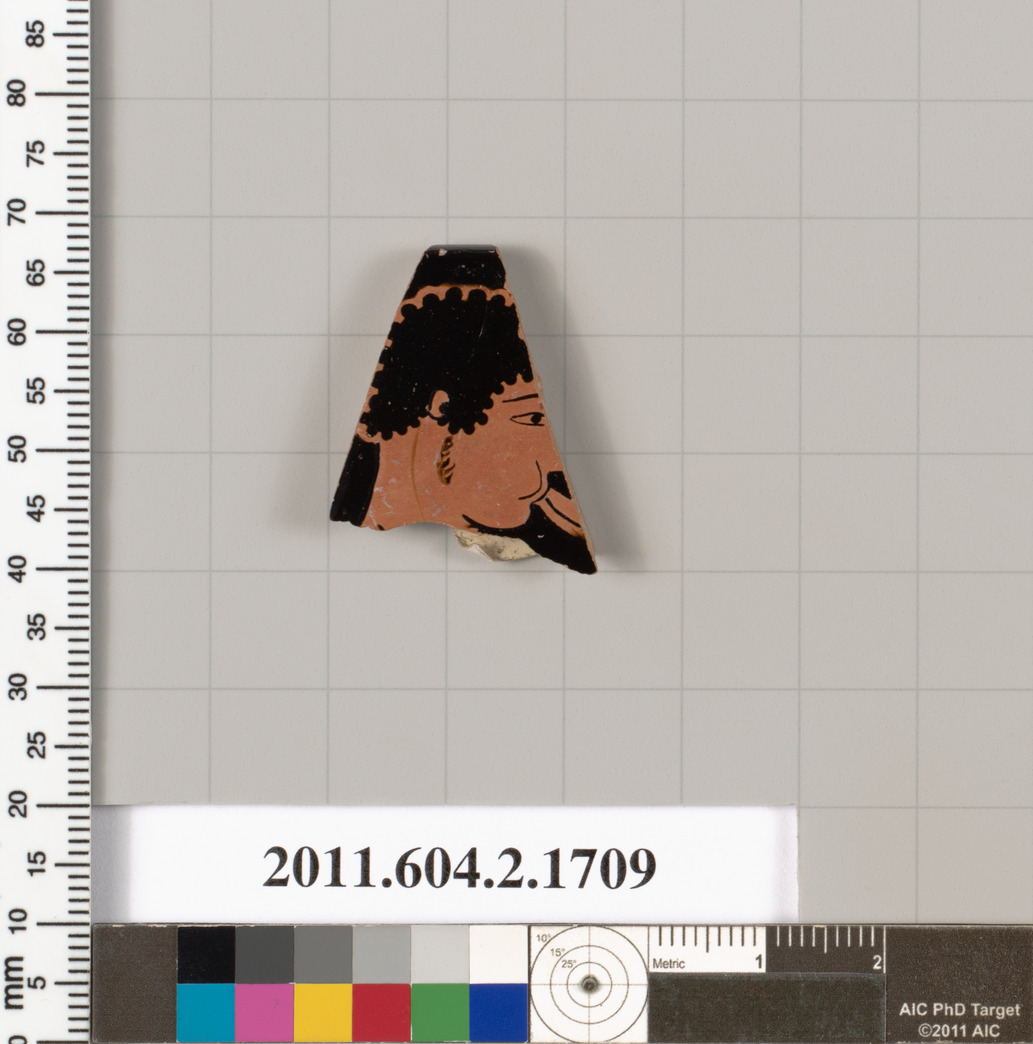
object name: skyphos fragment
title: Terracotta rim fragment of a skyphos (deep drinking cup)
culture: greek, attic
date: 500-480 BCE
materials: terracotta